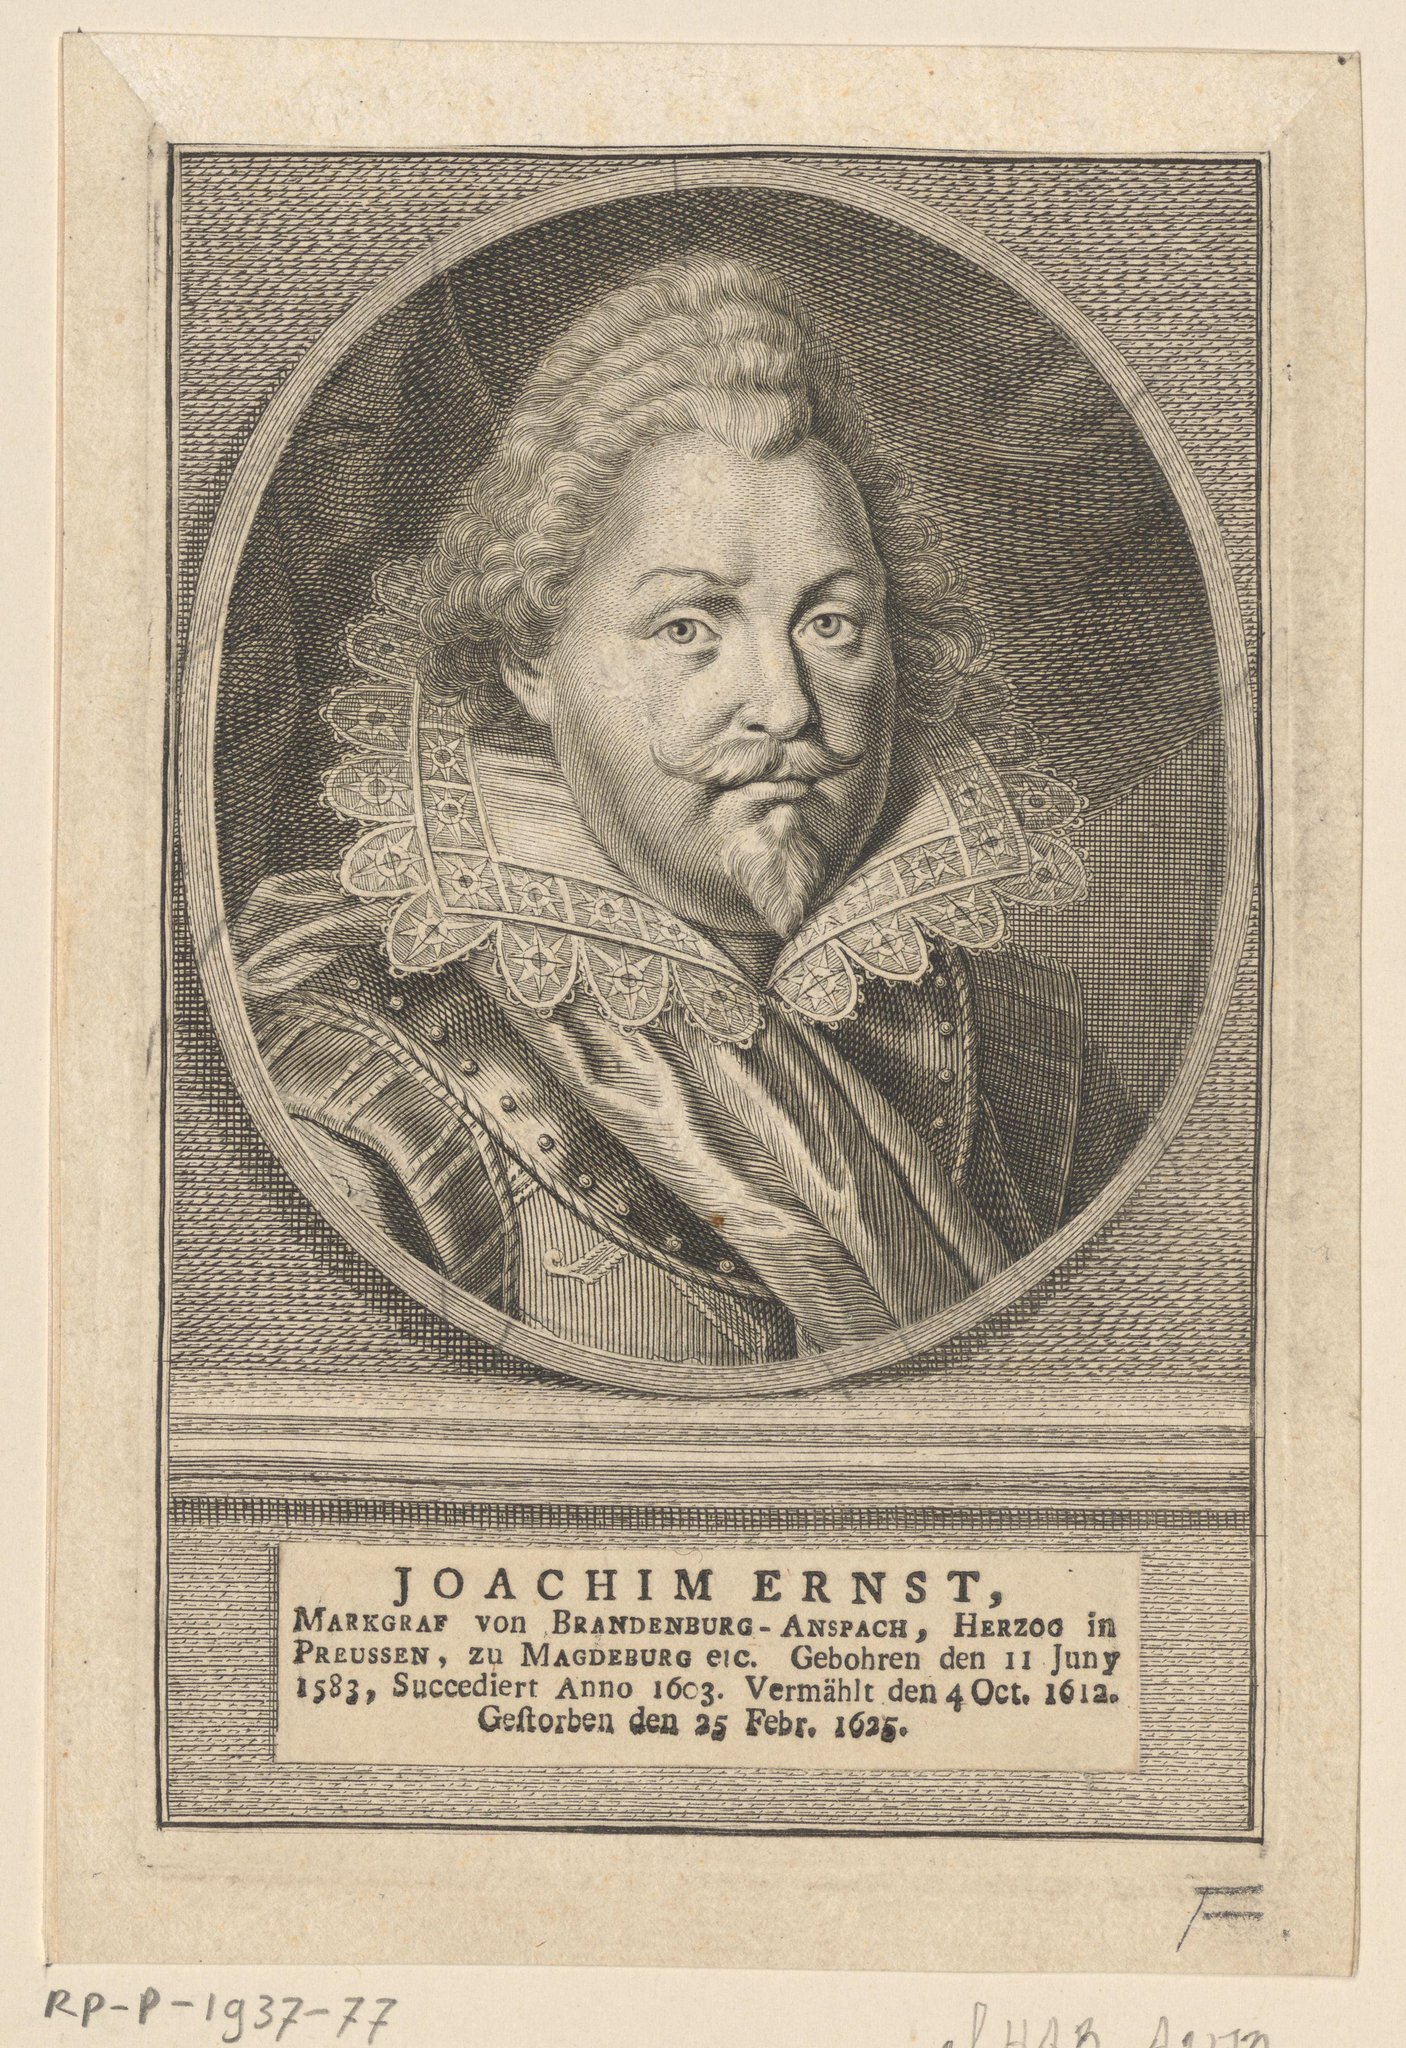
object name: print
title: Portret van Joachim Ernst van Brandenburg-Ansbach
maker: Anonymous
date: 1700-1799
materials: paper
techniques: engraving, letterpress printing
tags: historical persons, nobility and patriciate; chivalry, knighthood